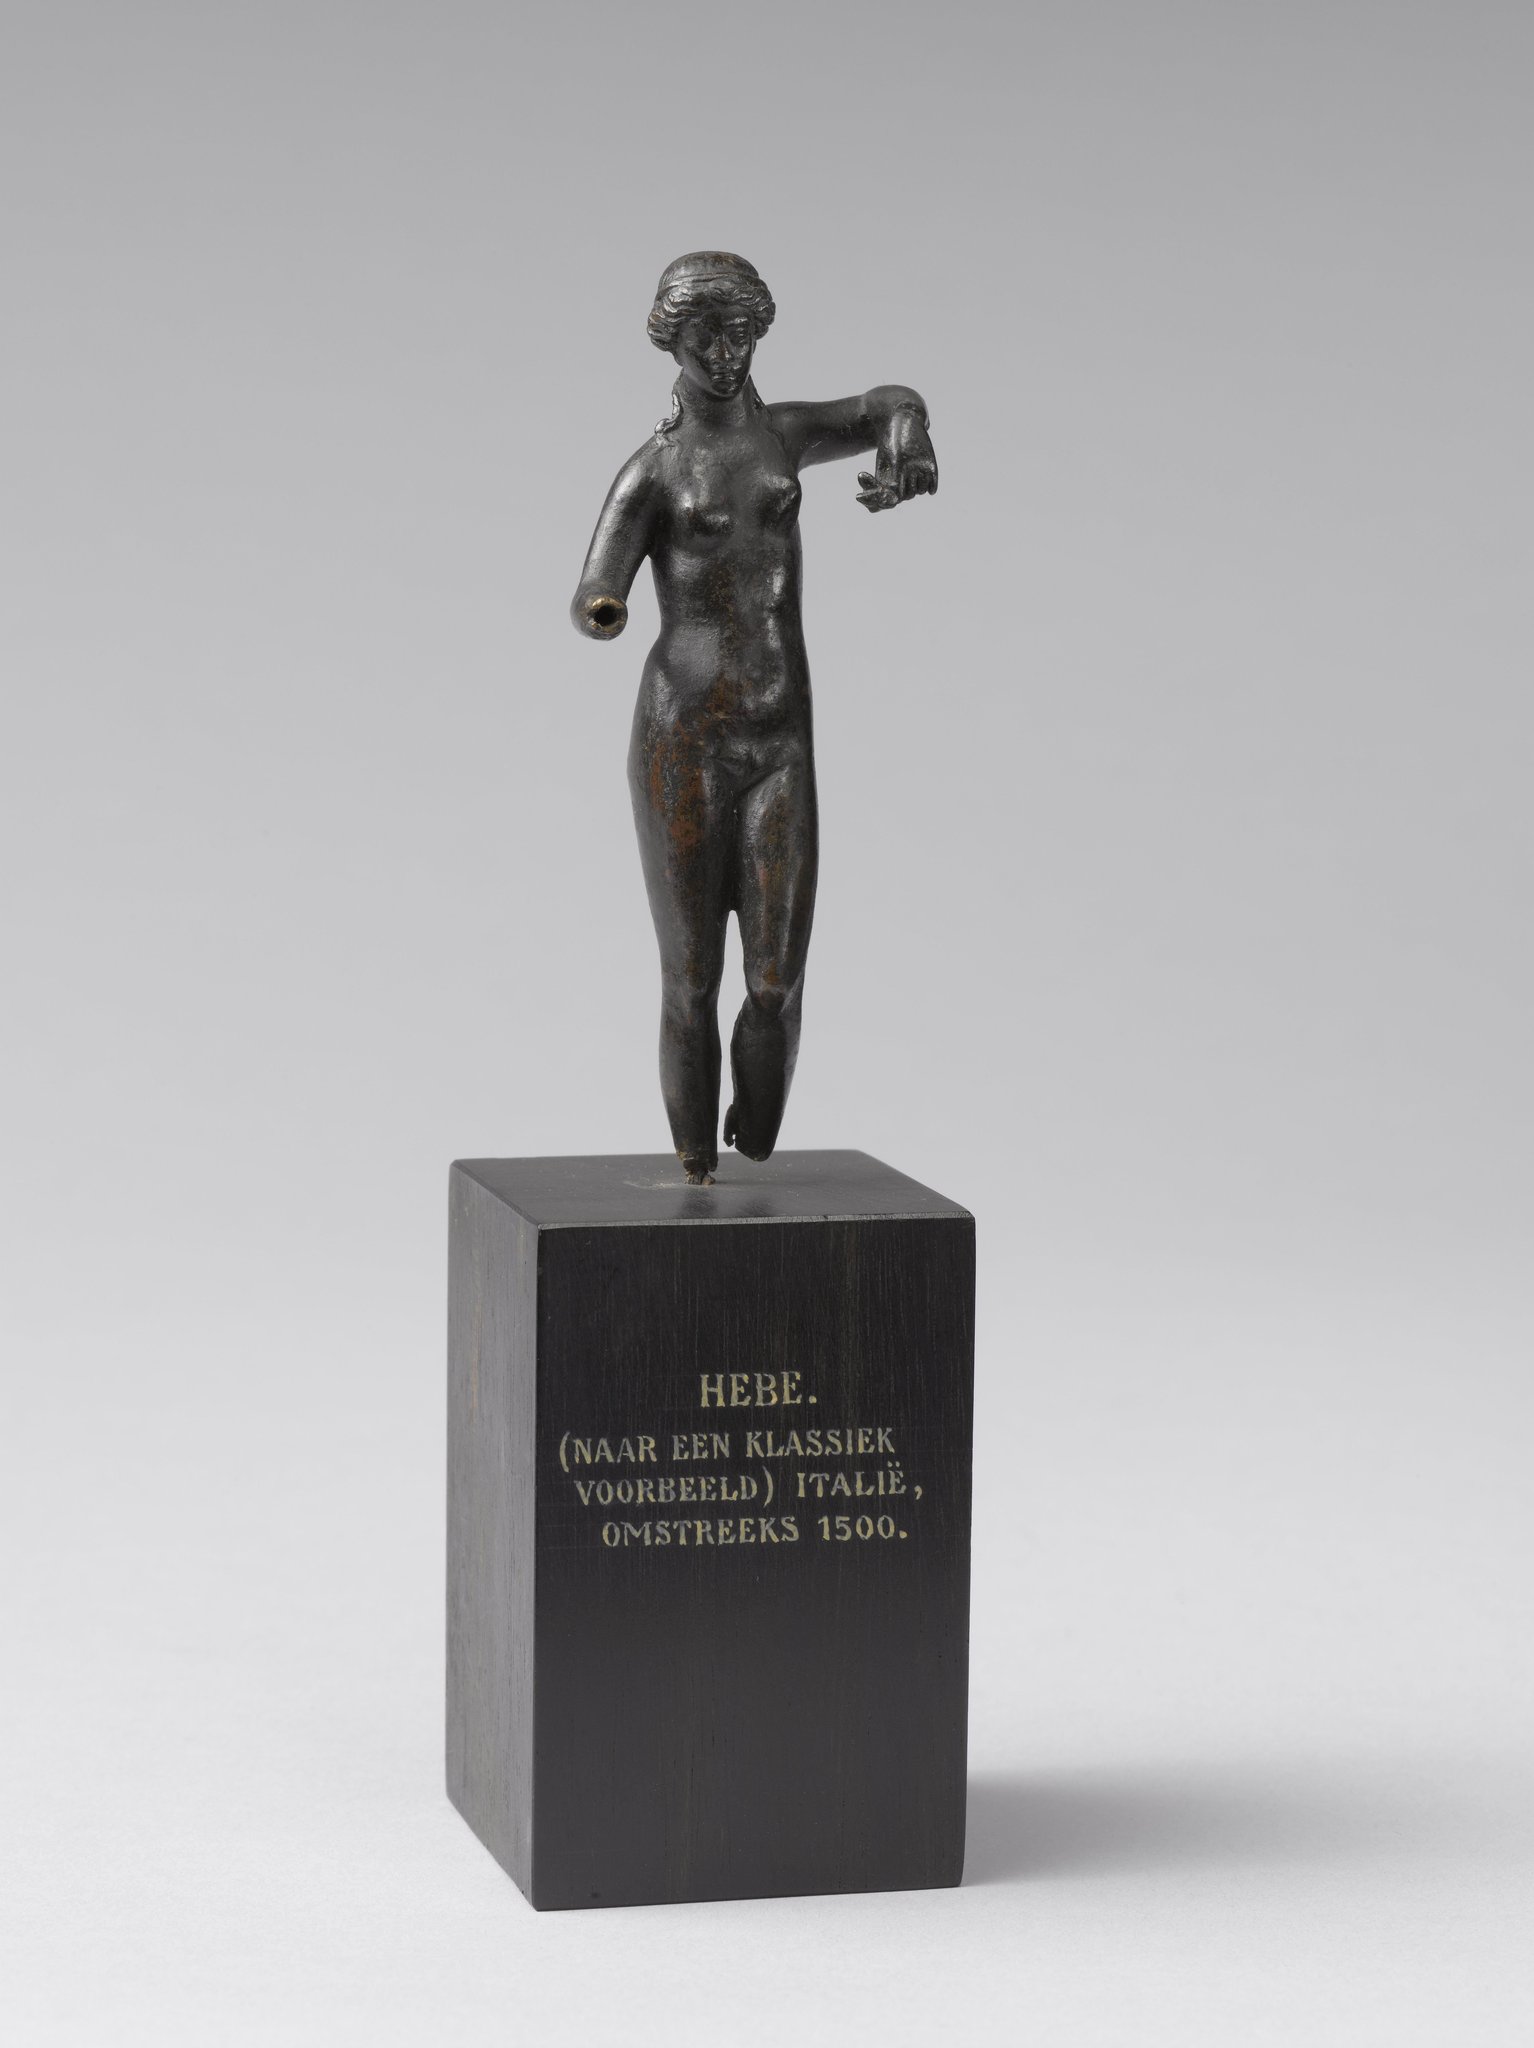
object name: sculpture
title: Naakte vrouwenfiguur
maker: Anonymous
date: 1525-1575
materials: bronze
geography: italy